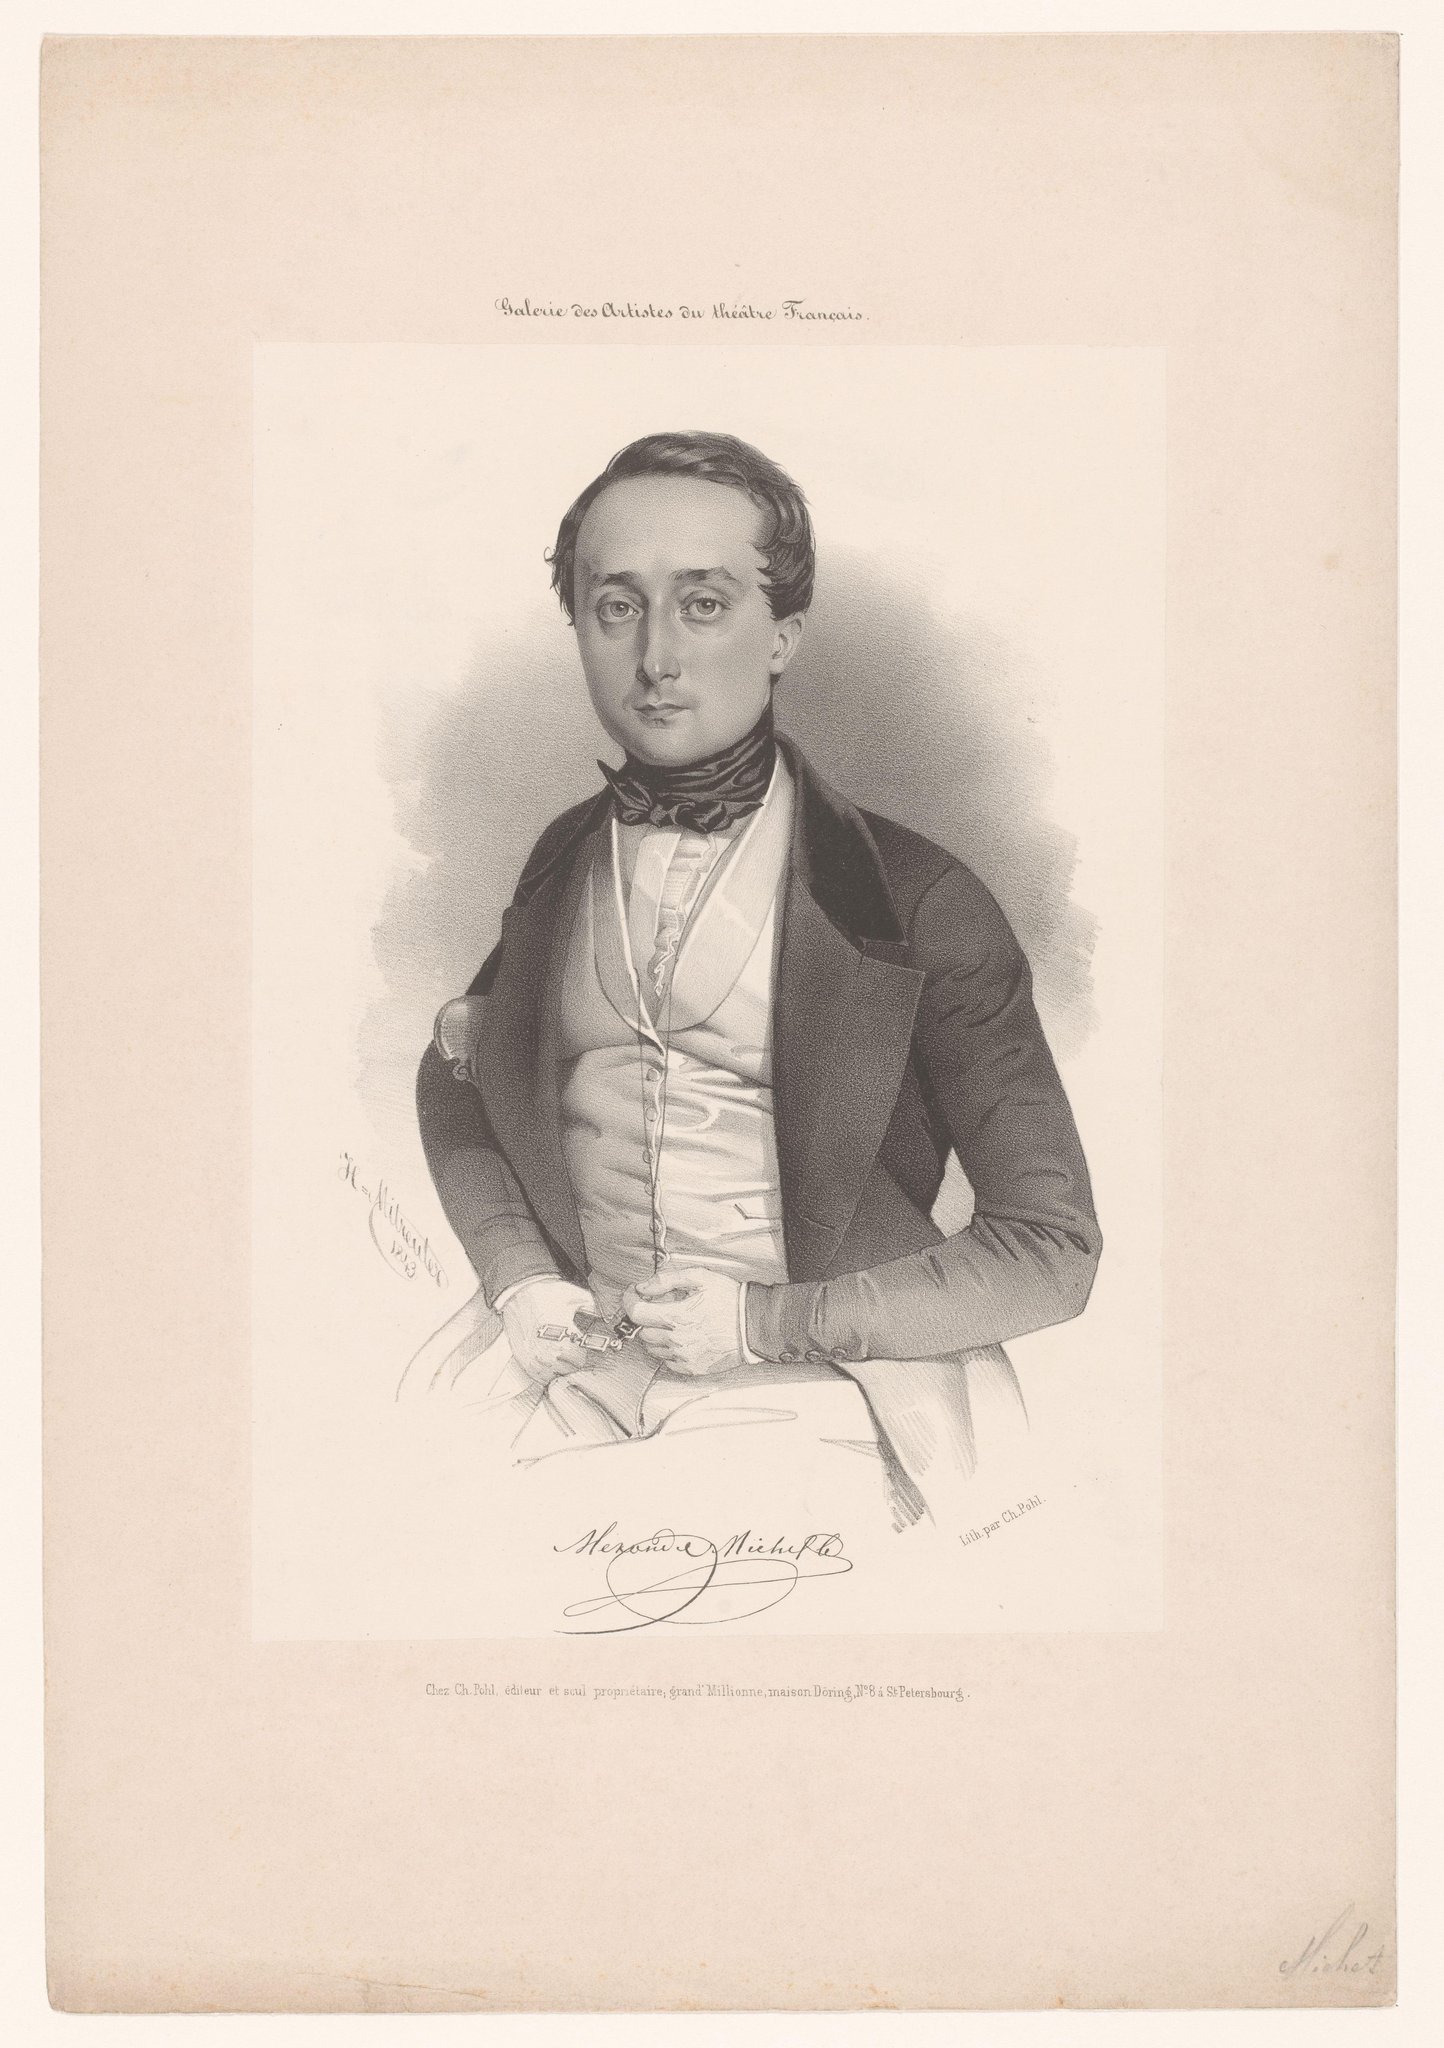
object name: print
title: Portret van een onbekende man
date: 1843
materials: paper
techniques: lithograph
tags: anonymous historical person portrayed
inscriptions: inscription: ‘Galerie des Artistes du théâtre Français.’, collector's mark: Lugt 2228, signature: ‘Lith. par Ch. Pohl.’, signature and date: ‘H = Mitreuter 1843’, signature: ‘Chez Ch. Pohl. éditeur et scul propriétaire; grand Millionne maison Döring, No 8 á St. Petersbourg.’, inscription: ‘Hekane Michet le’